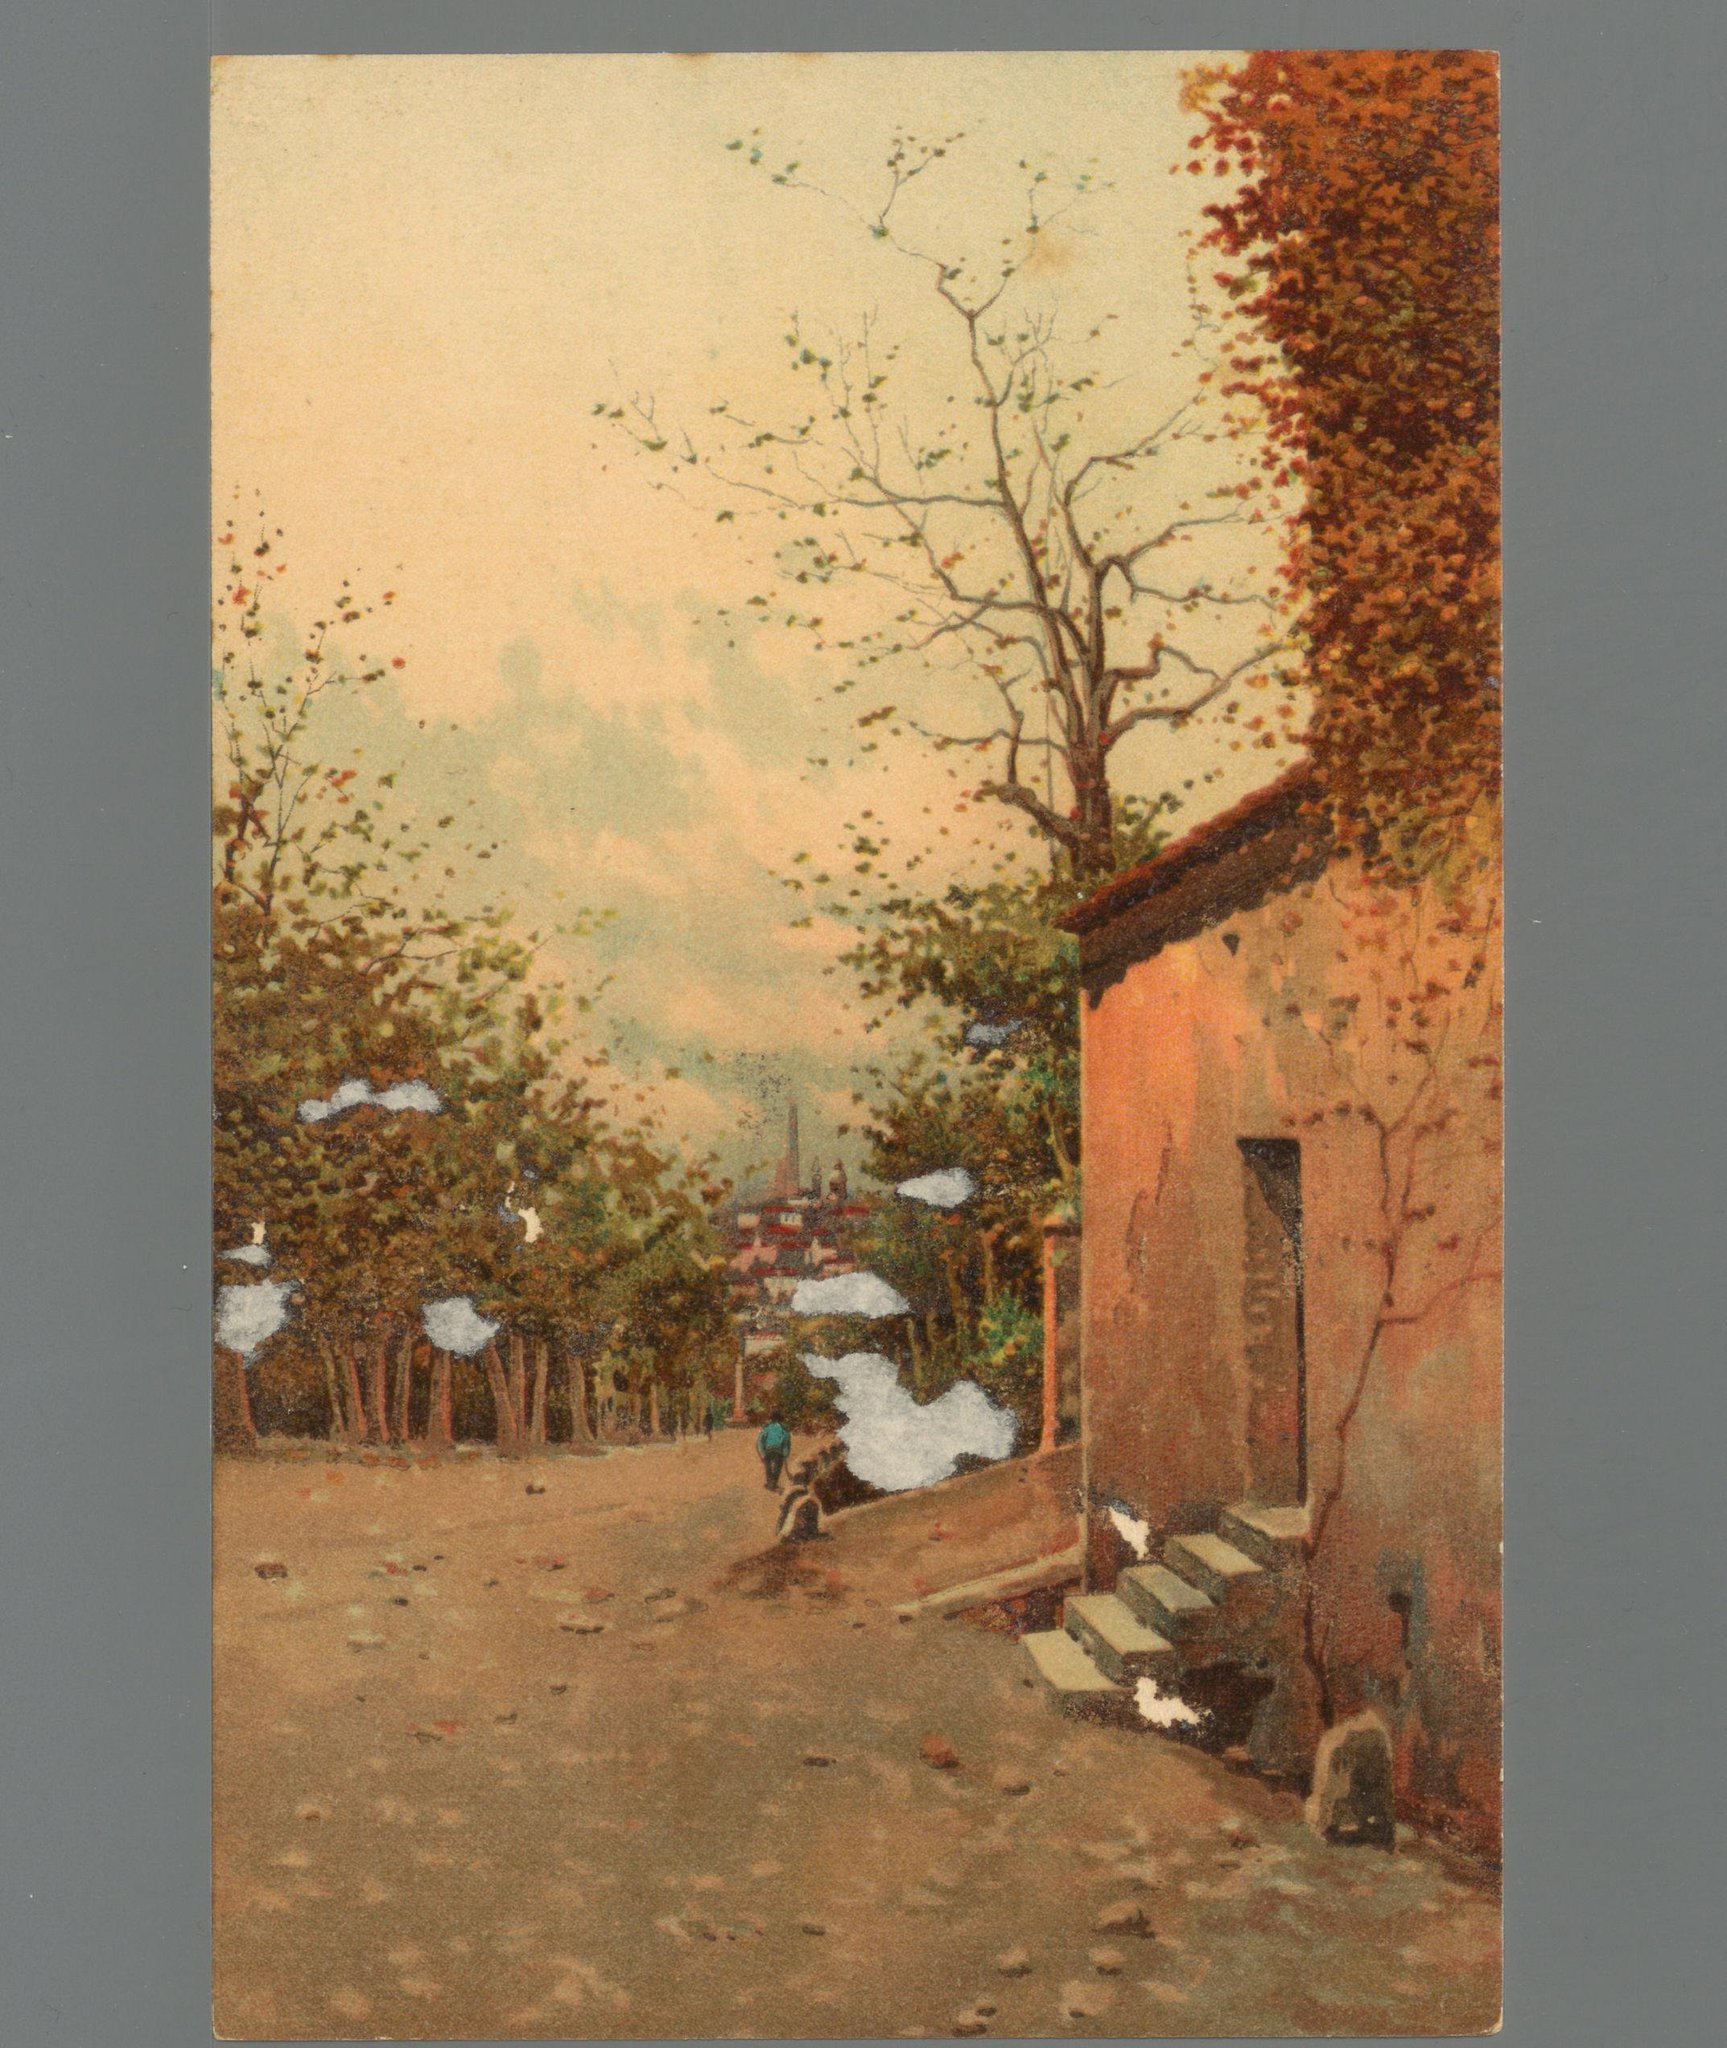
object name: print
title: Bologna. Strada dell'Osservanza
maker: Anonymous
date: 1905-1930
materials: cardboard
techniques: lithograph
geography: dresden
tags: cottage, mountains (+ landscape with figures, staffage)